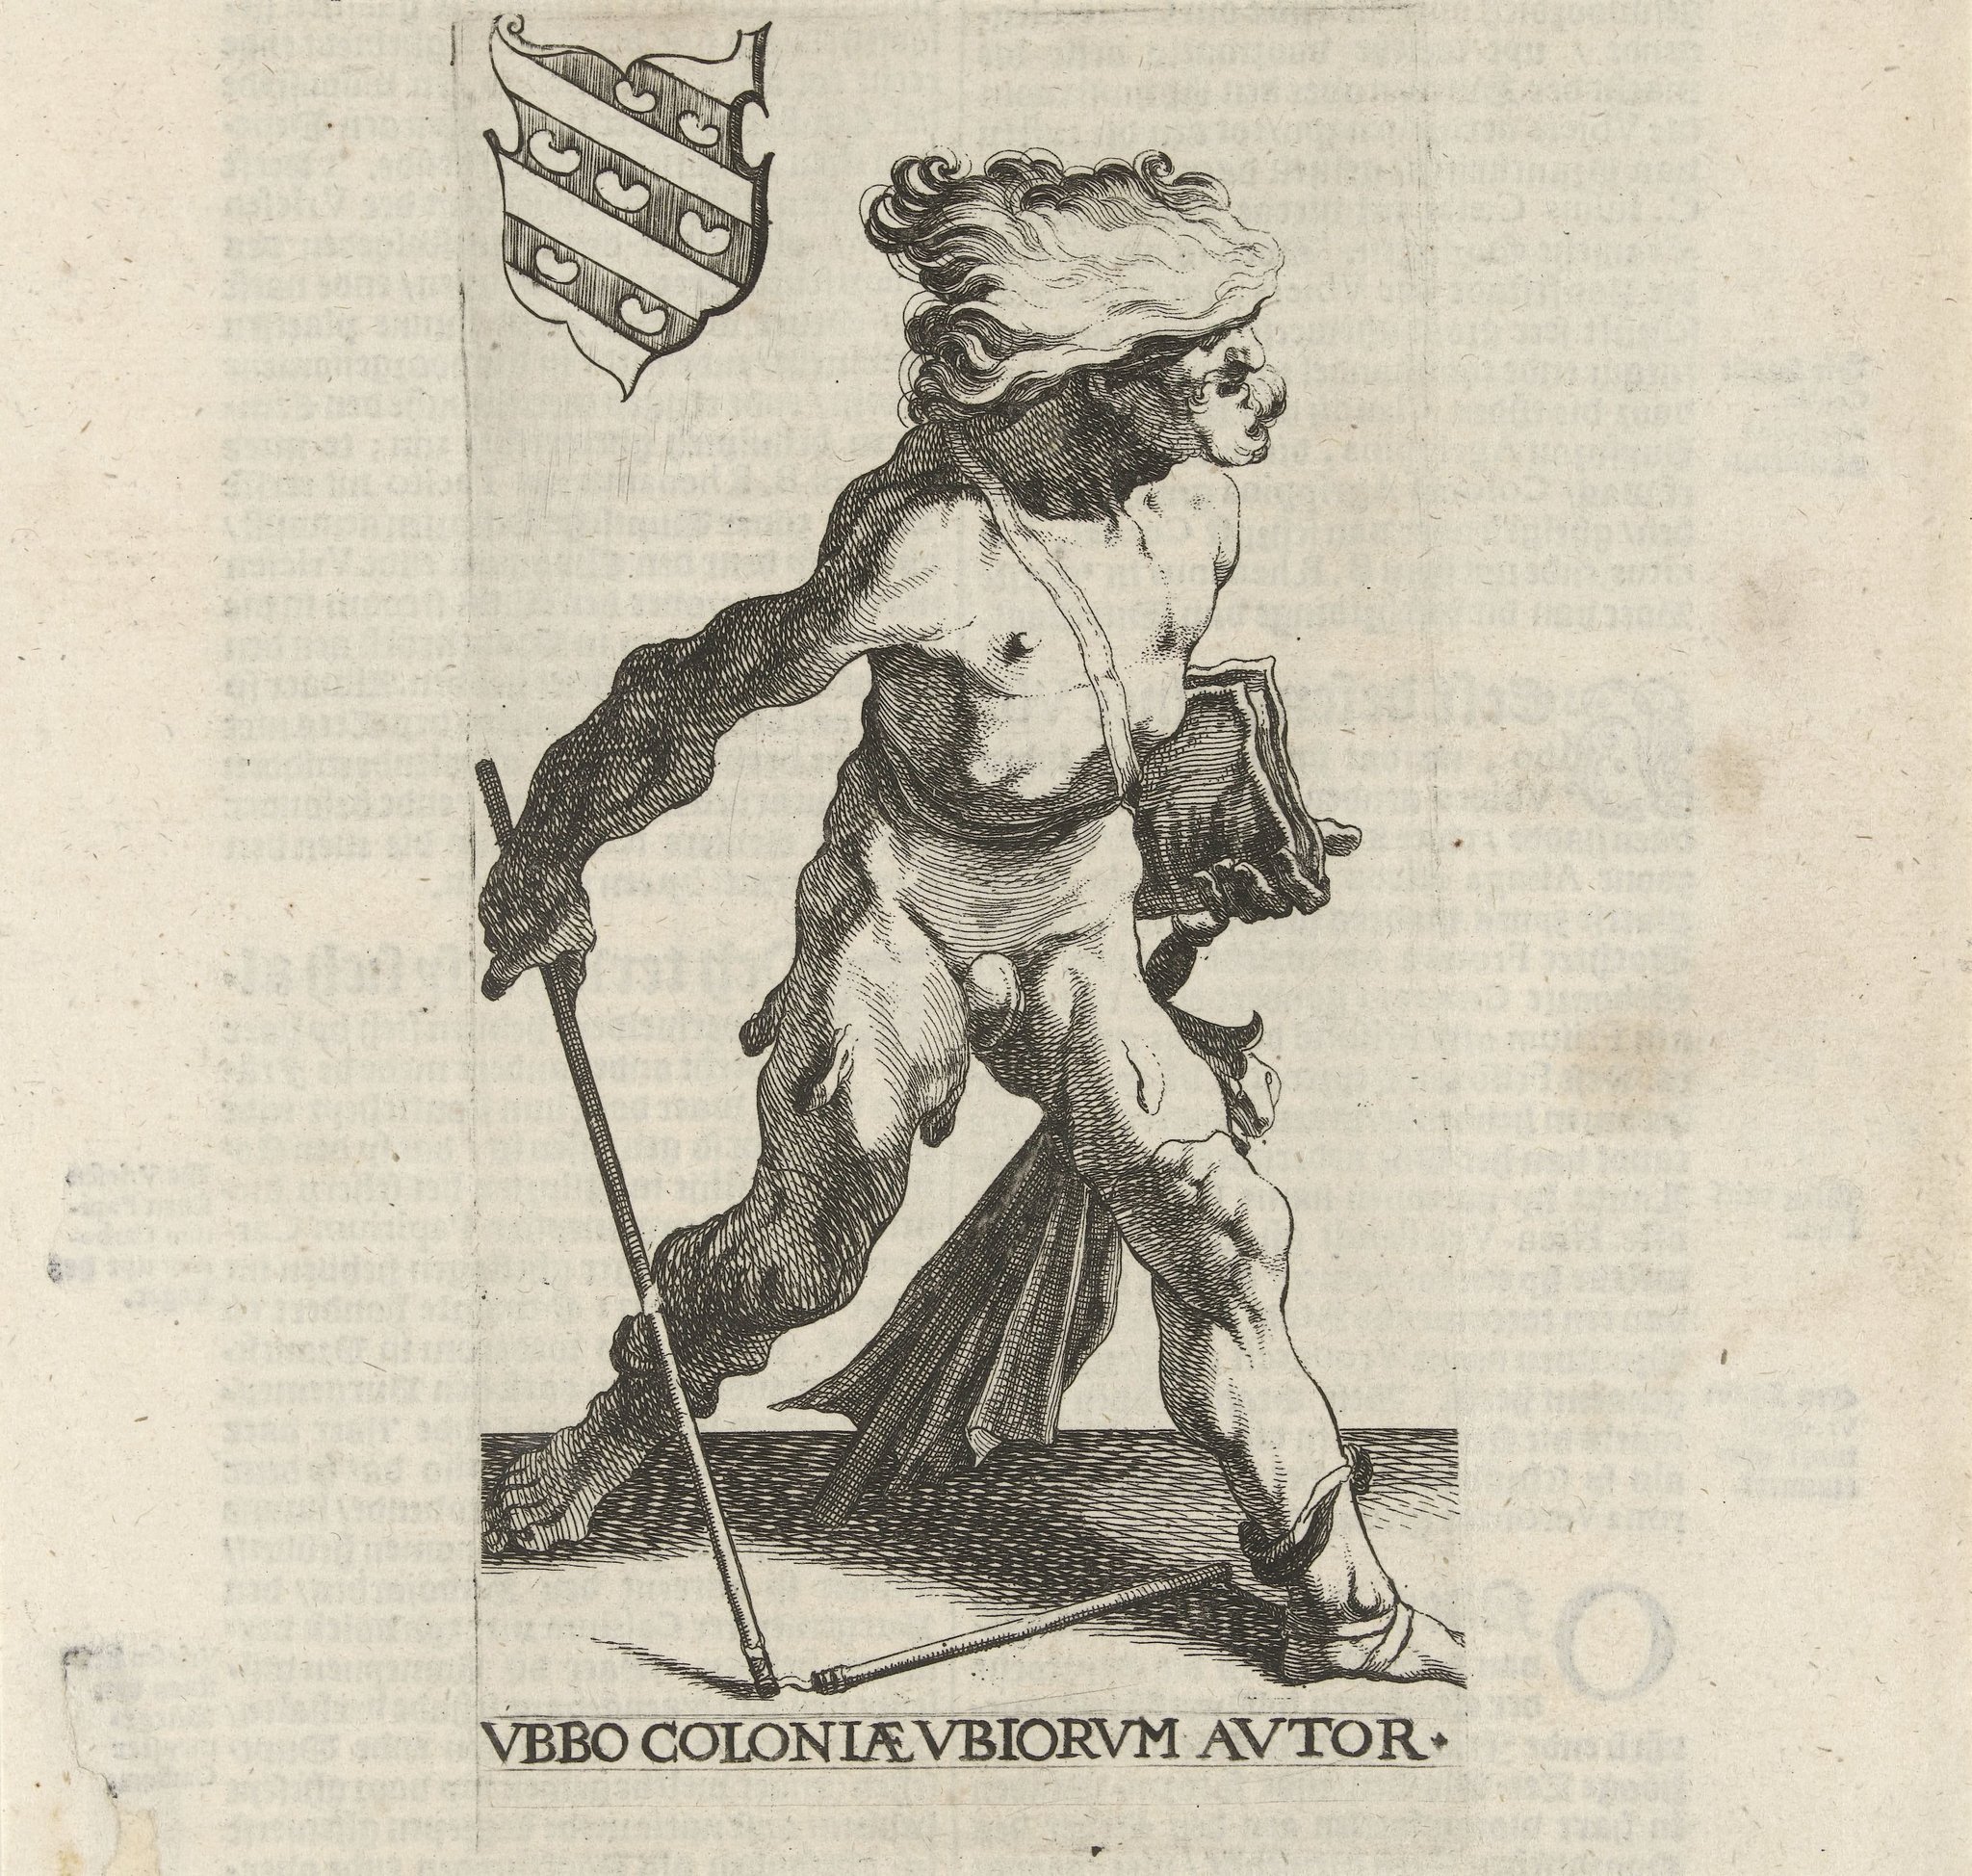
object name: print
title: Friese heersers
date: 1622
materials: paper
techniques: etching, letterpress printing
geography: franeker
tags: ubbo (prins der friezen)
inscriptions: collector's mark: Lugt 2228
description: De prent is ook als boekillustratie gebruikt in: Winsemius, P.W. Chronique ofte Historische geschiedenisse van Vrieslant (...). Franeker: Joannes Lamrinck, 1622.